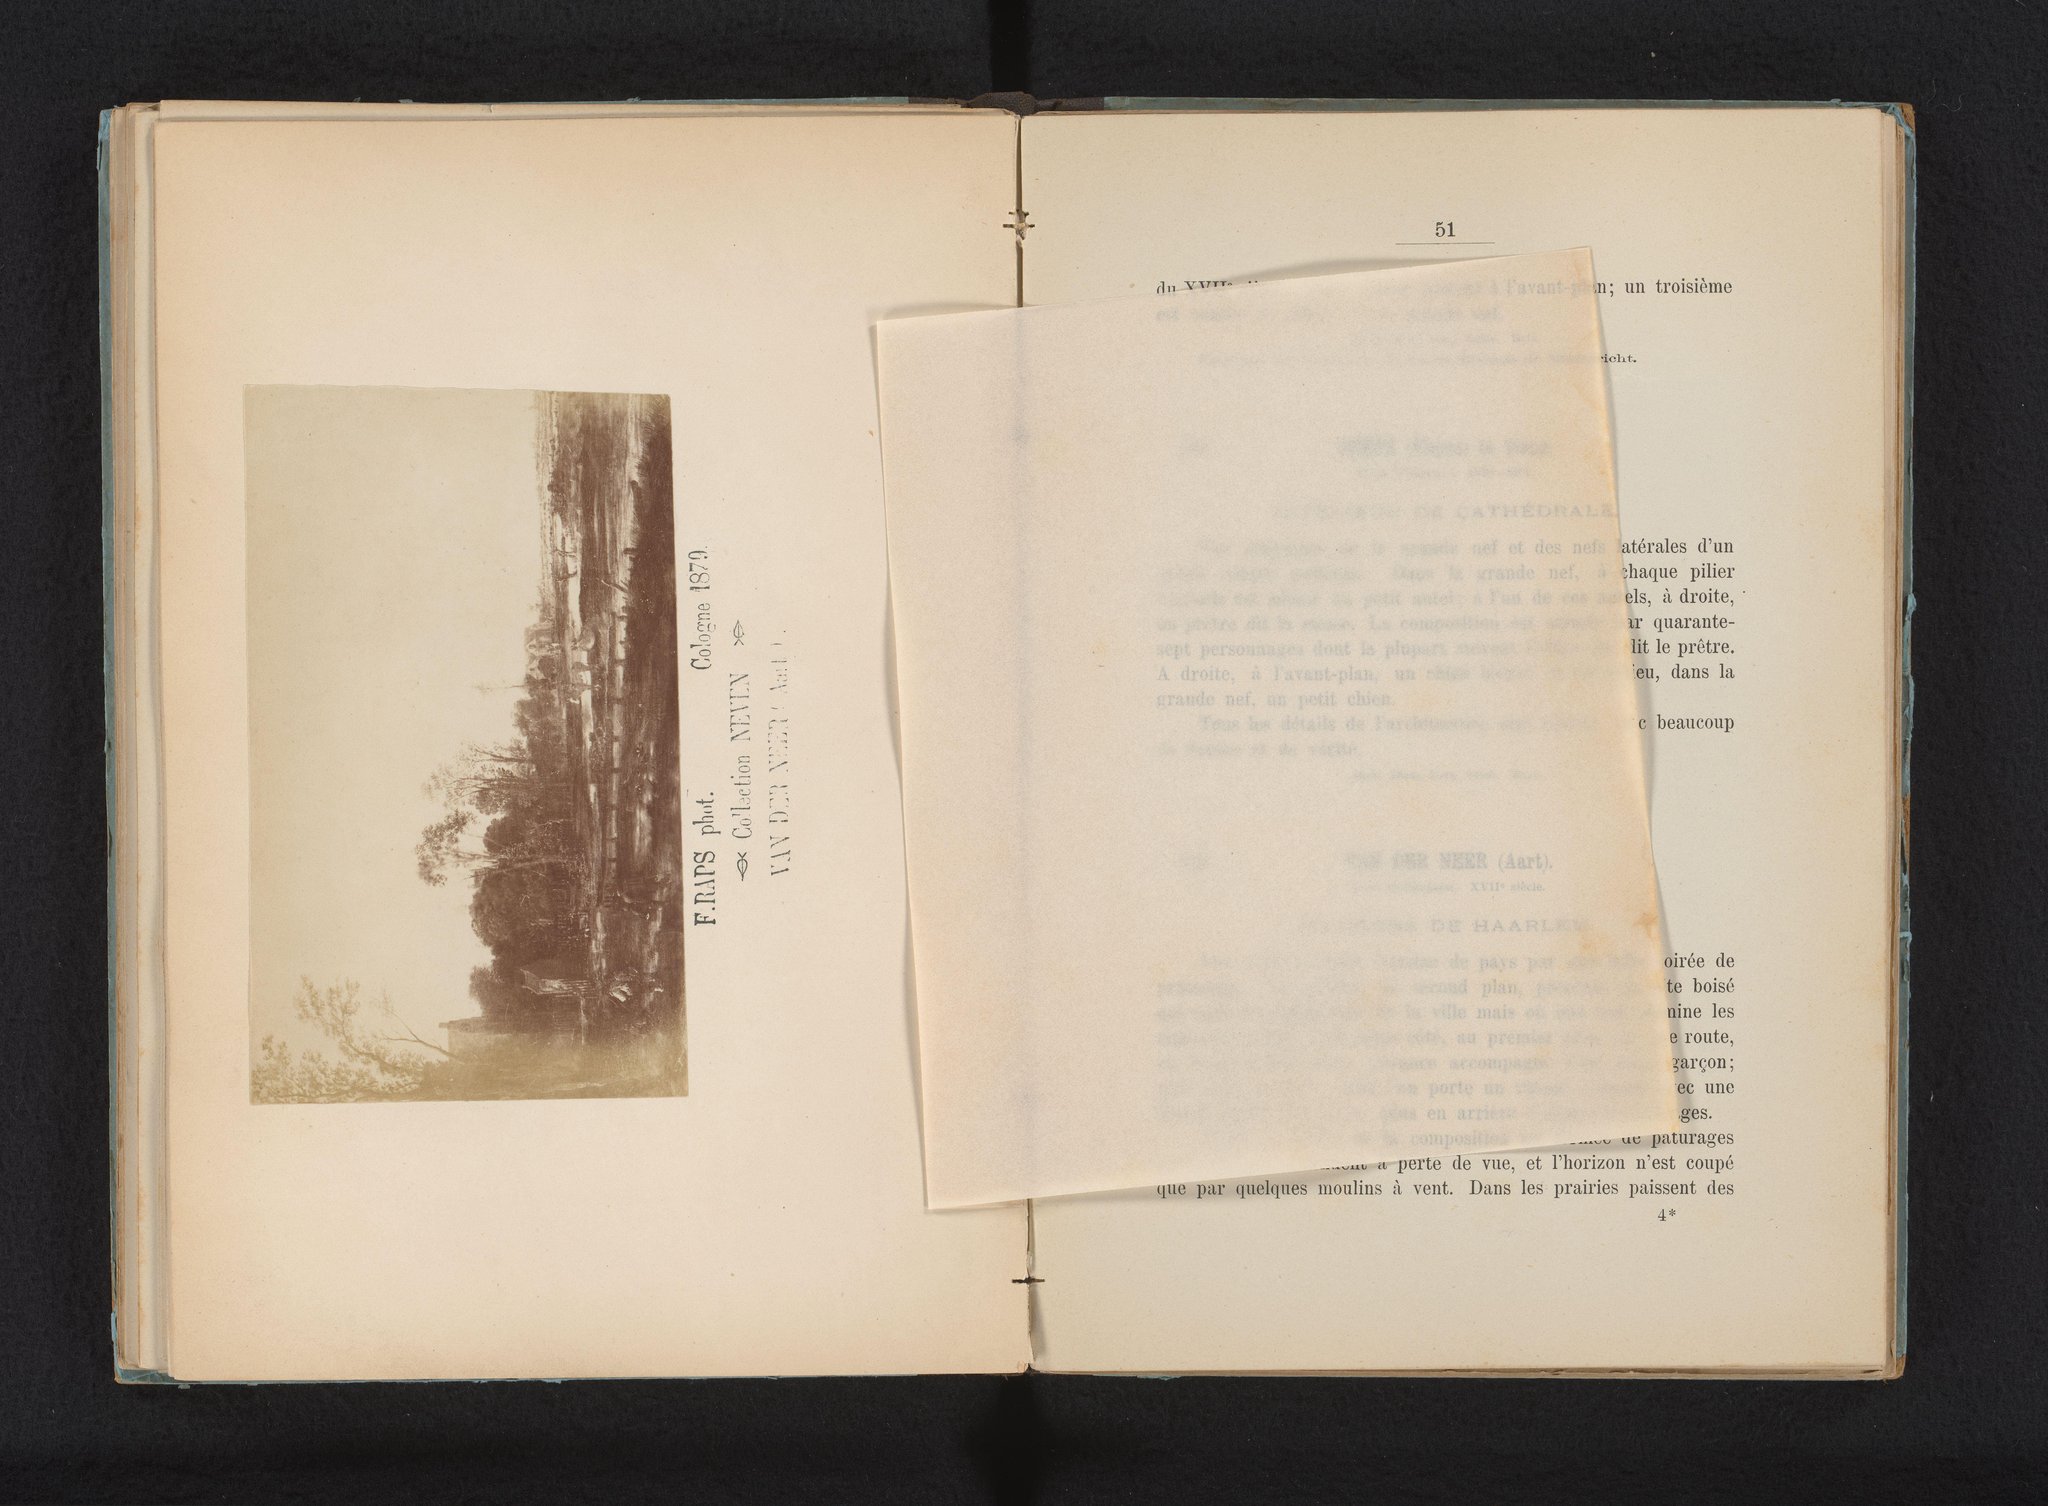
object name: reproduction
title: Fotoreproductie van een schilderij van een landschap nabij Haarlem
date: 1879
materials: photographic support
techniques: albumen print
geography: cologne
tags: landscapes (+ landscape with figures, staffage)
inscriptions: inscription: ‘Collection NEVEN/ Van der Neer (Aart).’